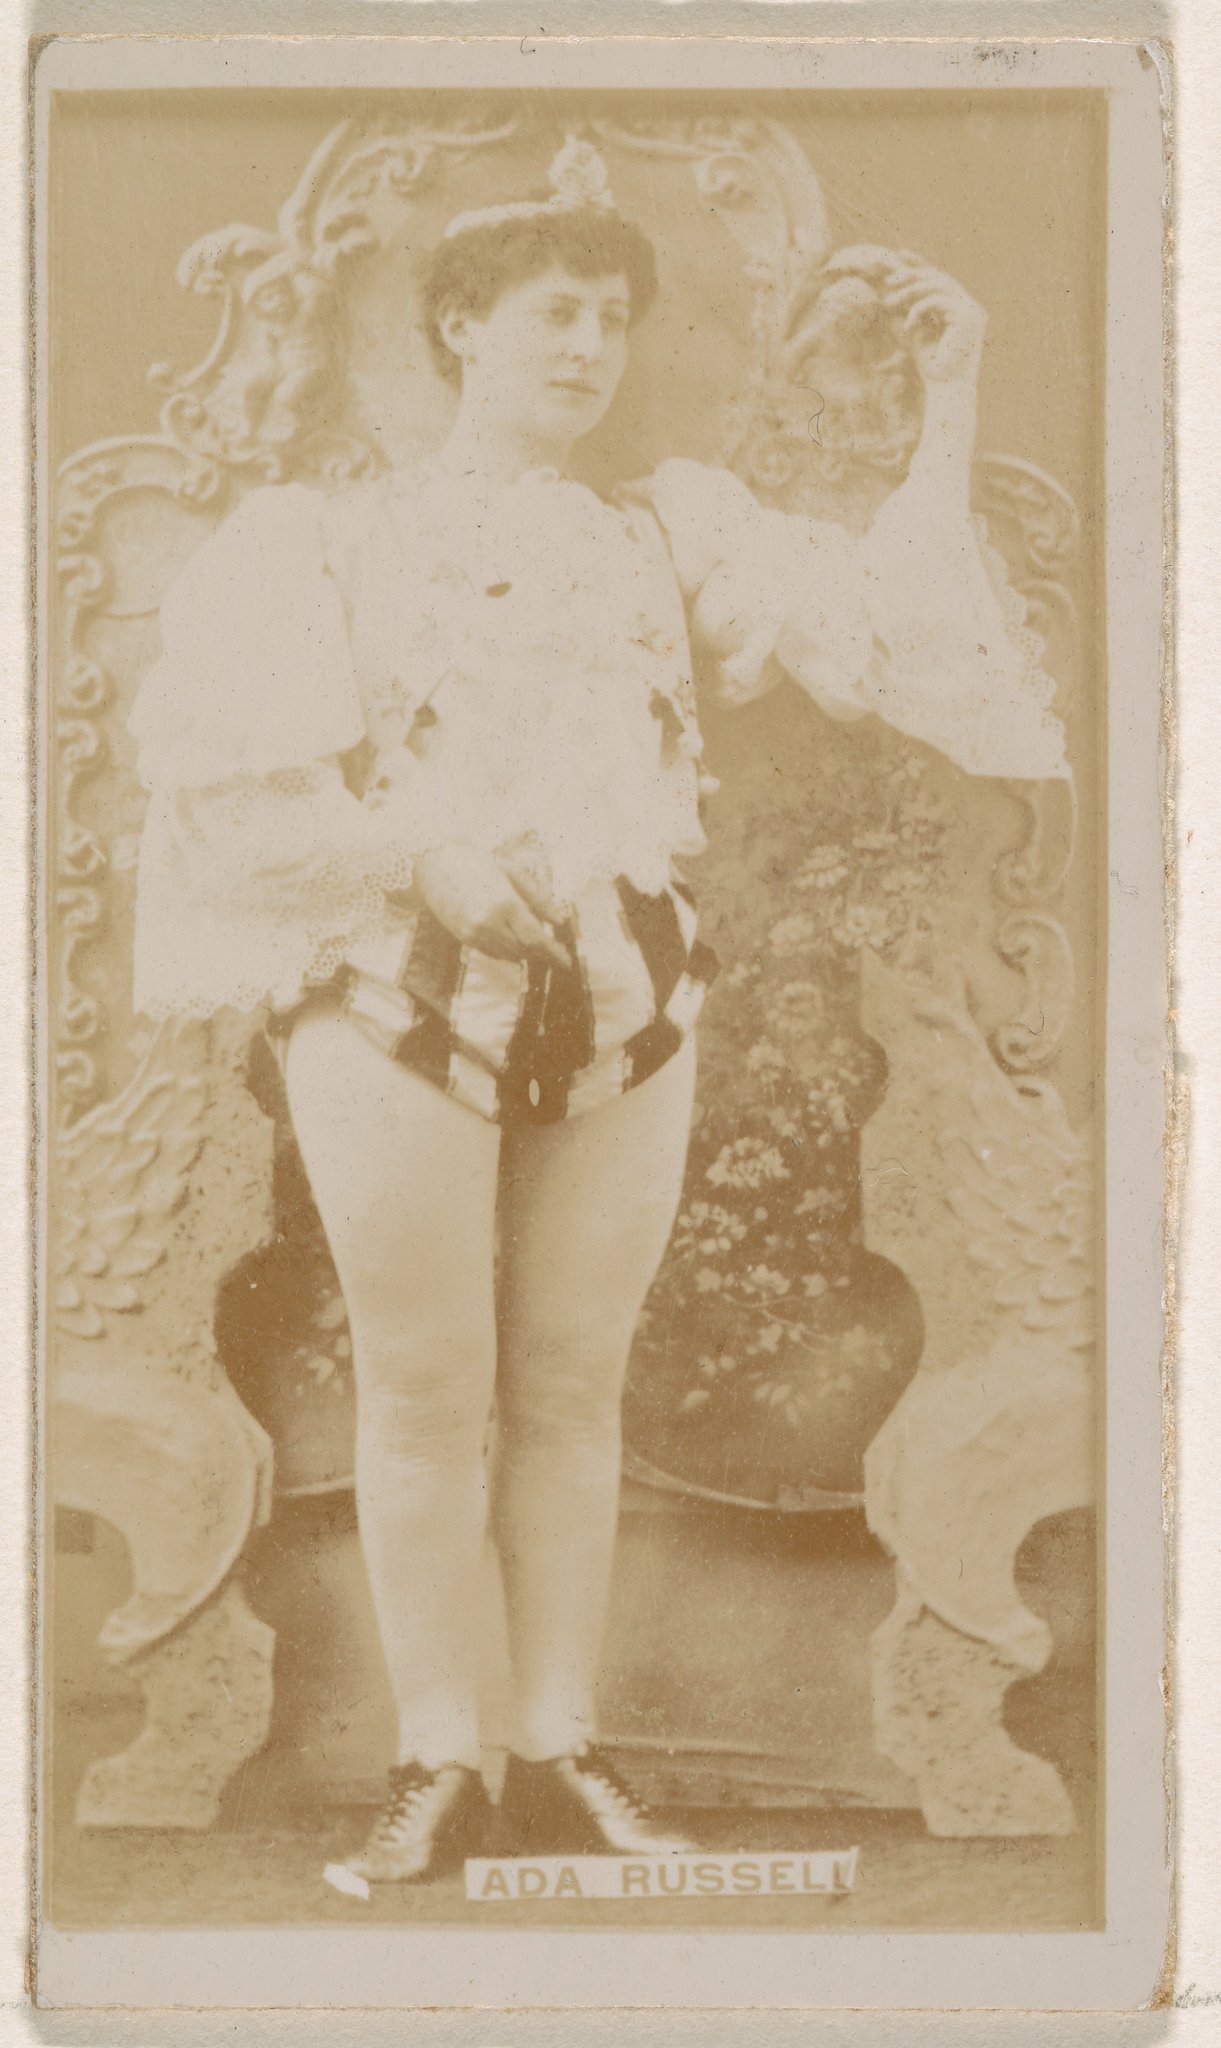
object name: photograph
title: Ada Russell, from the Actresses series (N245) issued by Kinney Brothers to promote Sweet Caporal Cigarettes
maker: kinney brothers tobacco company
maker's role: publisher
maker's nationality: american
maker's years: 1869-2011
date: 1890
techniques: albumen silver print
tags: portraits,women,actresses